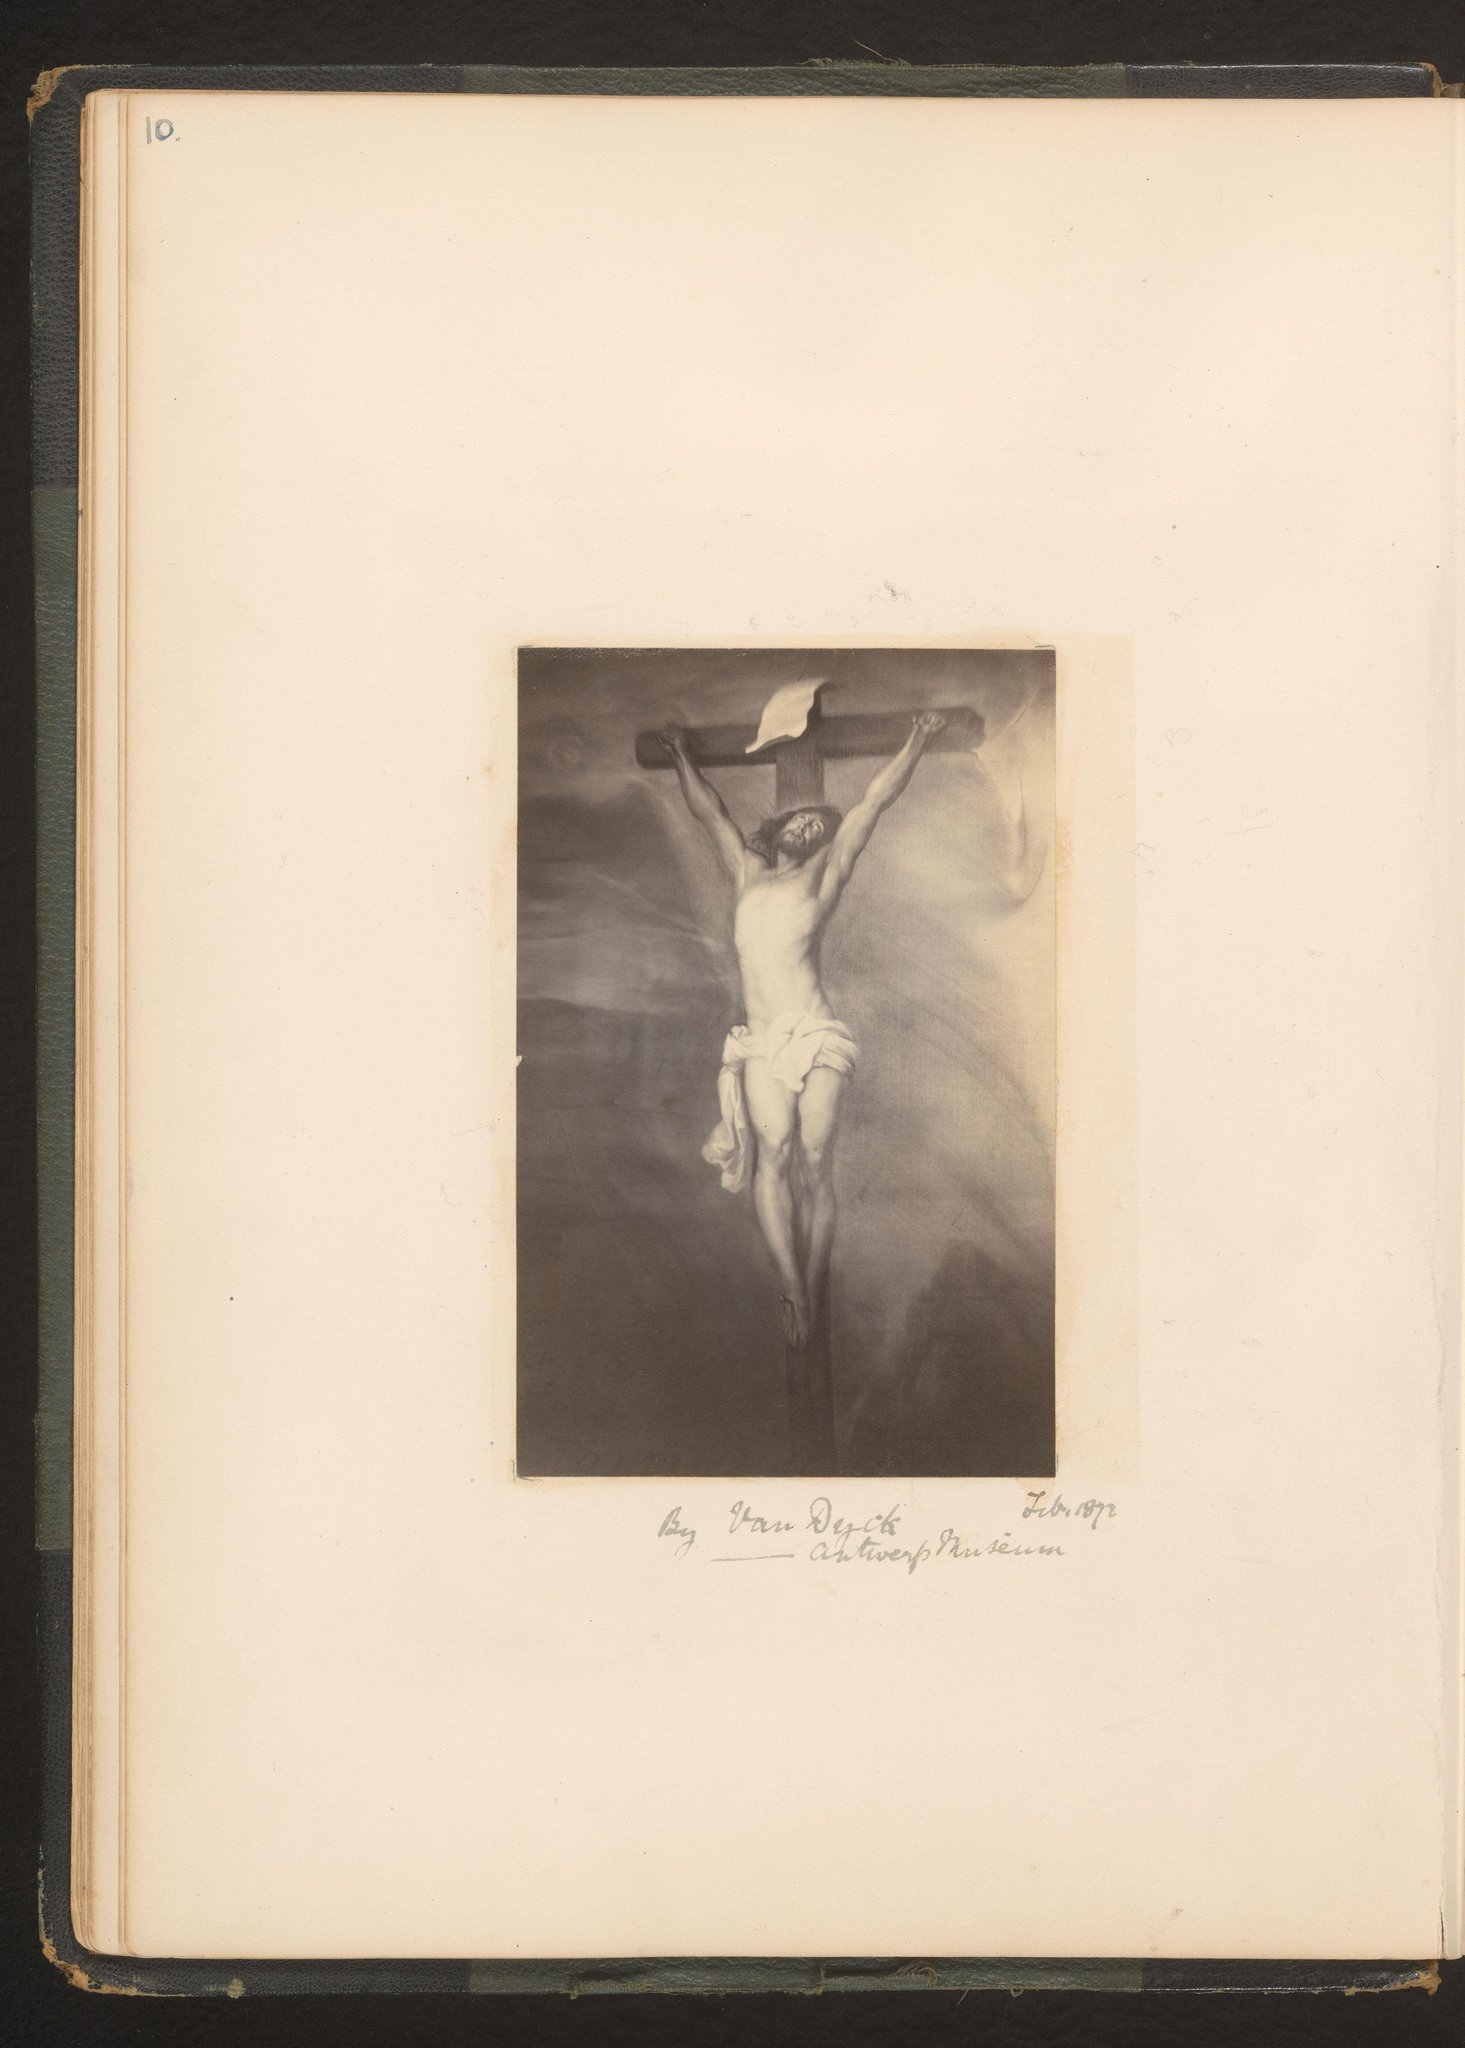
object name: album leaf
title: Fotoreproductie van Christus aan het kruis door Anthony van Dyck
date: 1802-1871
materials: paper, photographic support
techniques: albumen print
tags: picture, painting, the crucifixion of christ: christ's death on the cross; golgotha (matthew 27:45-58; mark 15:33-45; luke 23:44-52; john 19:25-38)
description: Deze pagina maakt deel uit van een album.